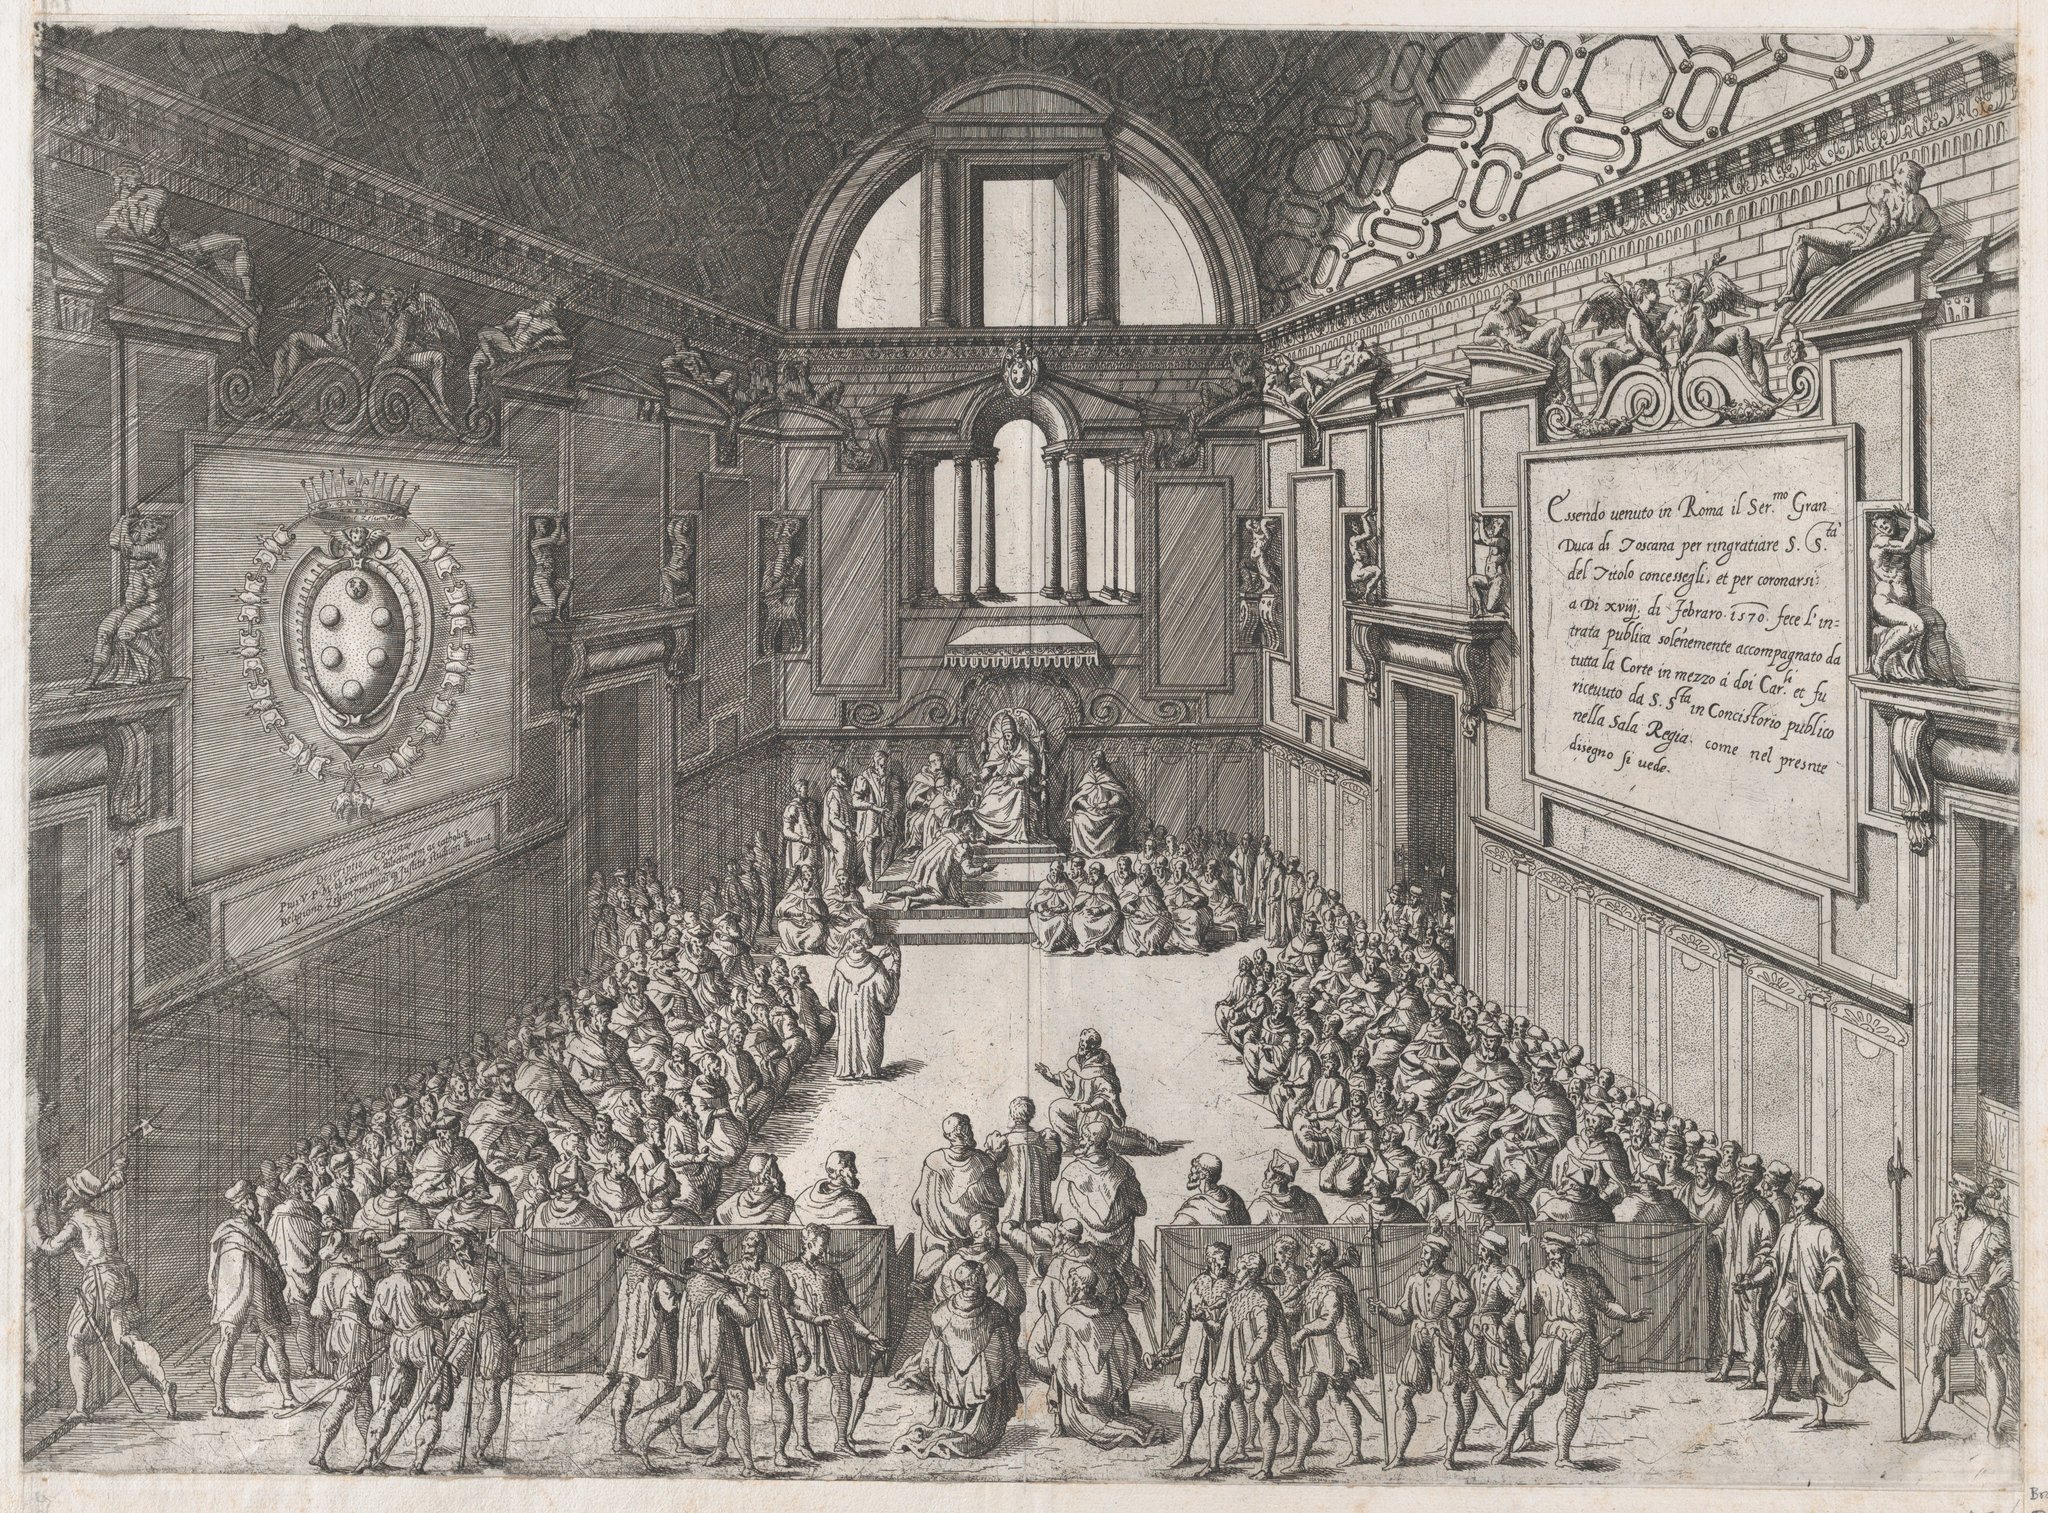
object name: print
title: Vatican Reception of the Duke of Tuscany, from "Speculum Romanae Magnificentiae"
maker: etienne dupérac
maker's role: artist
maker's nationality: french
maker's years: 1535-1604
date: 1570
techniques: engraving, etching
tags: men,ceremony,crowd,coat of arms,rome